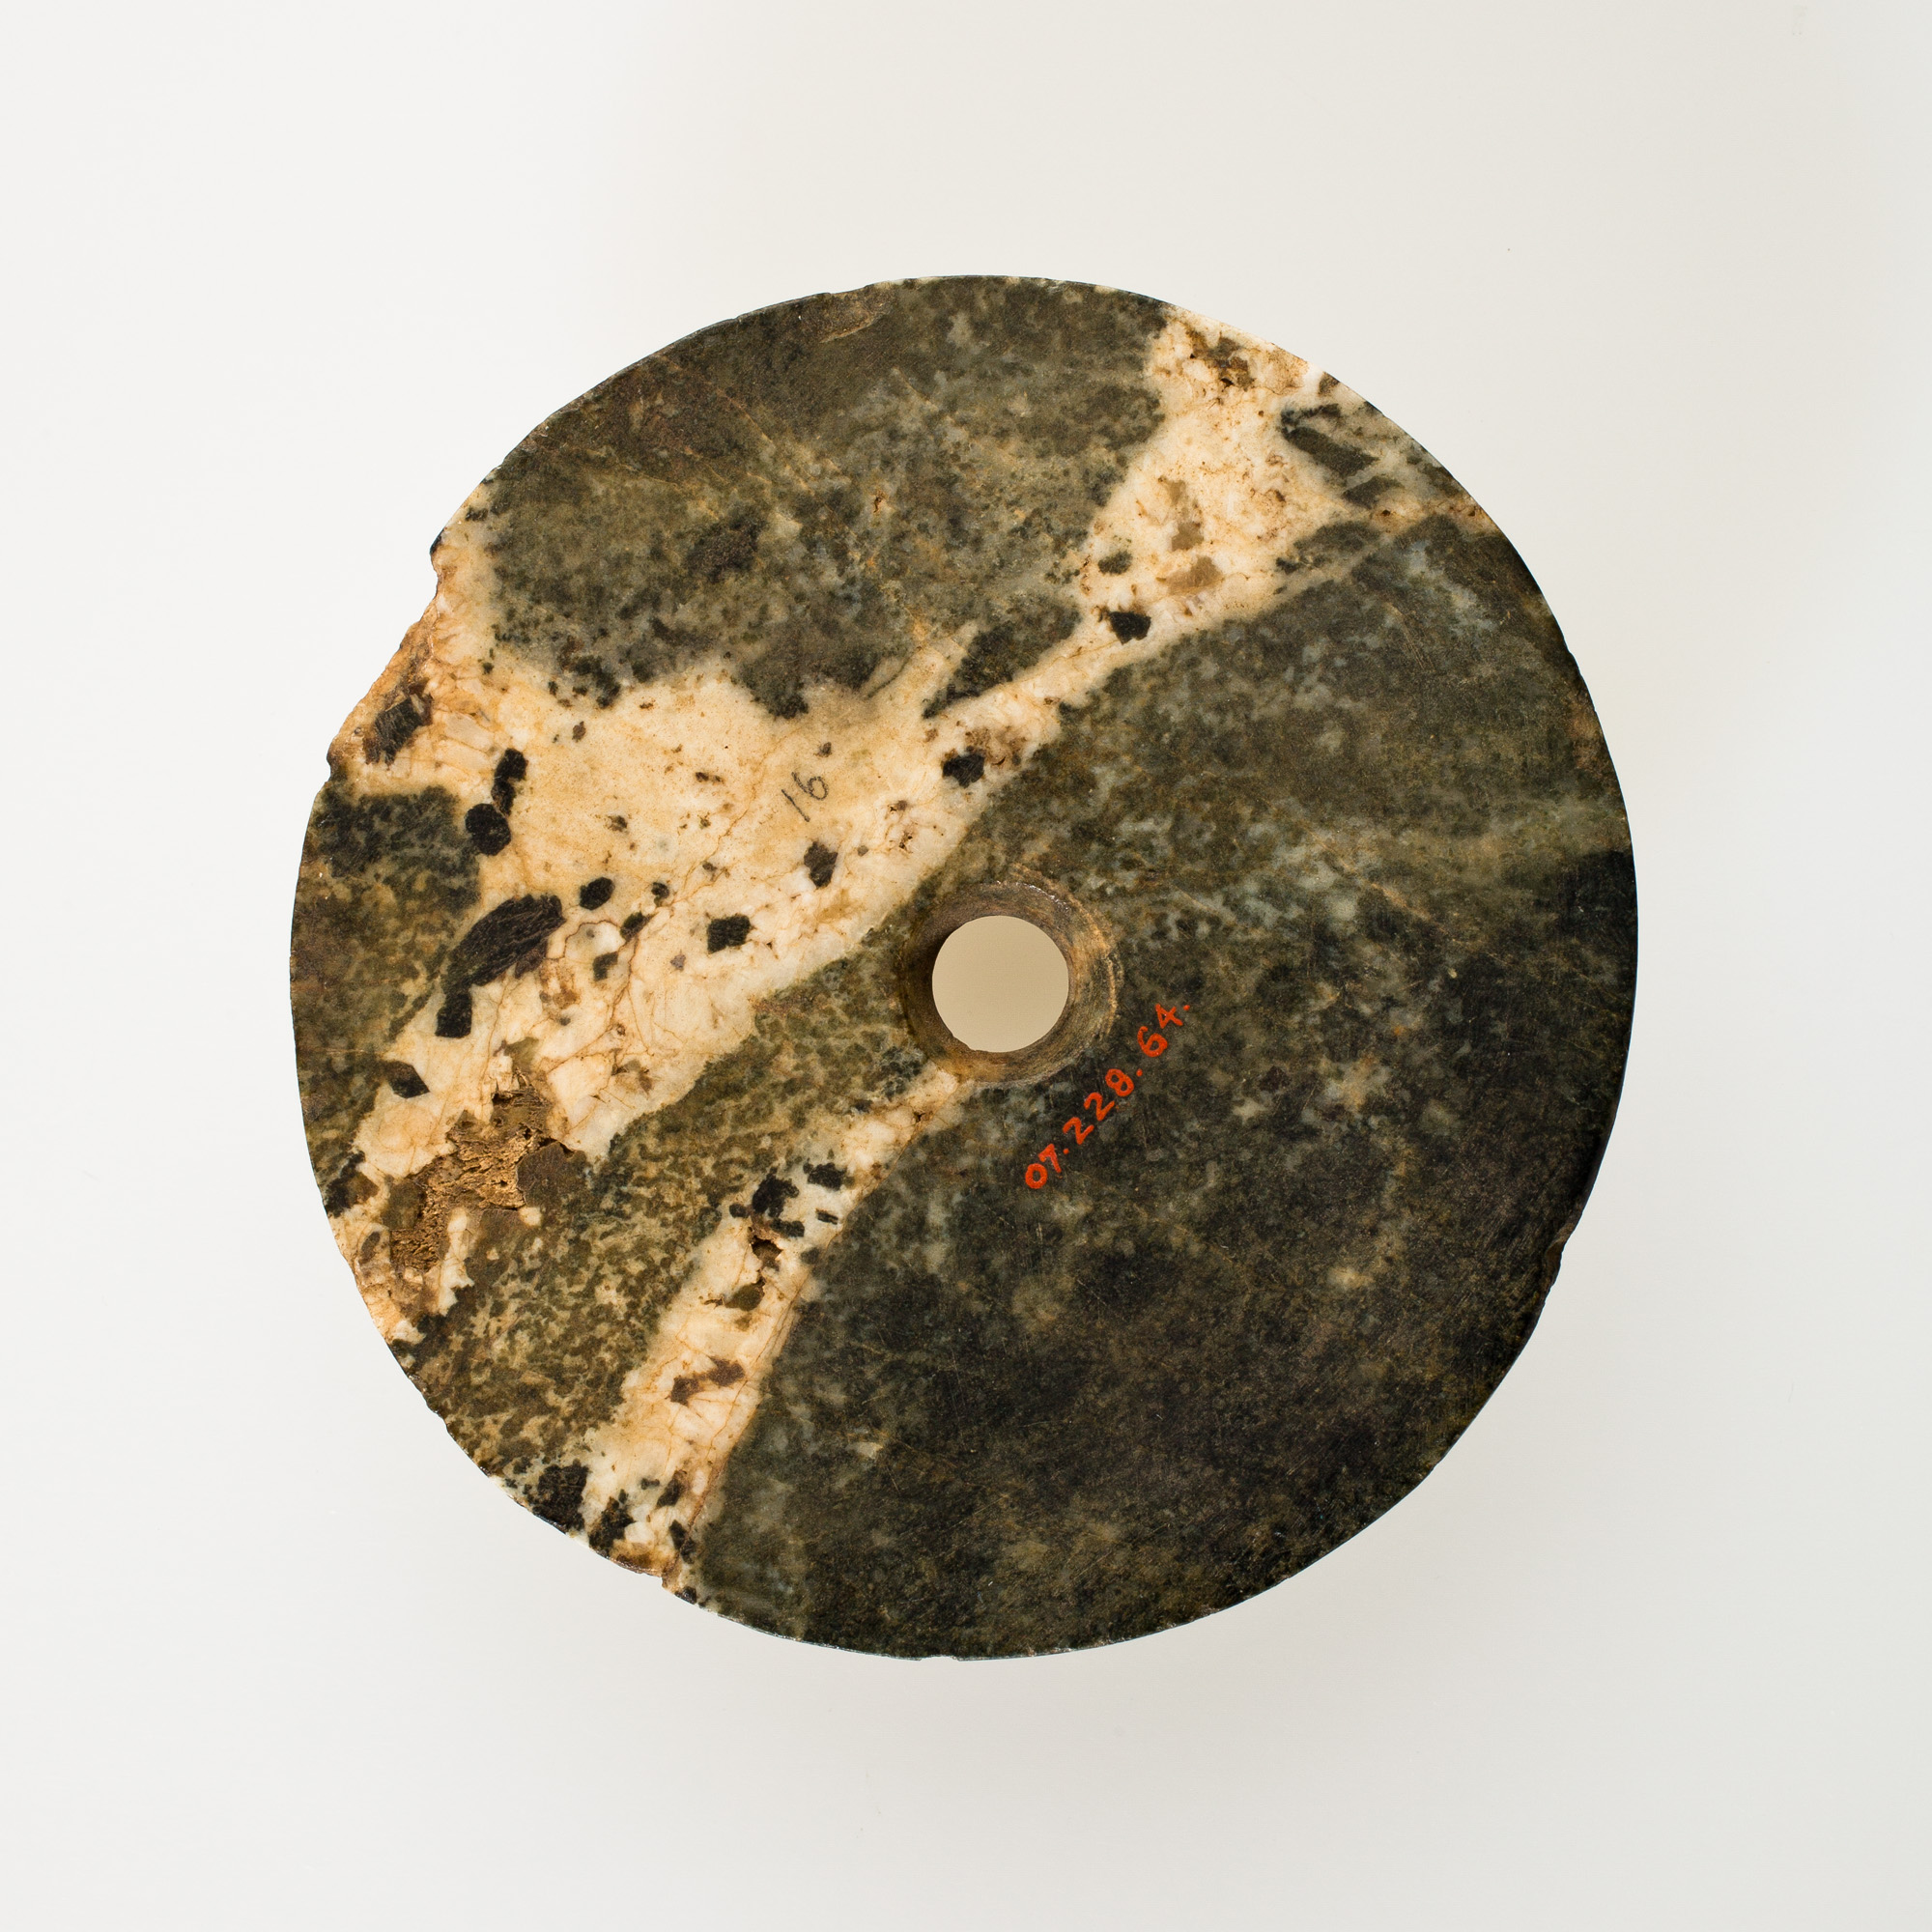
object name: mace head, disc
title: Disc-shaped mace head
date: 4500-4000 BCE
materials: stone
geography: egypt